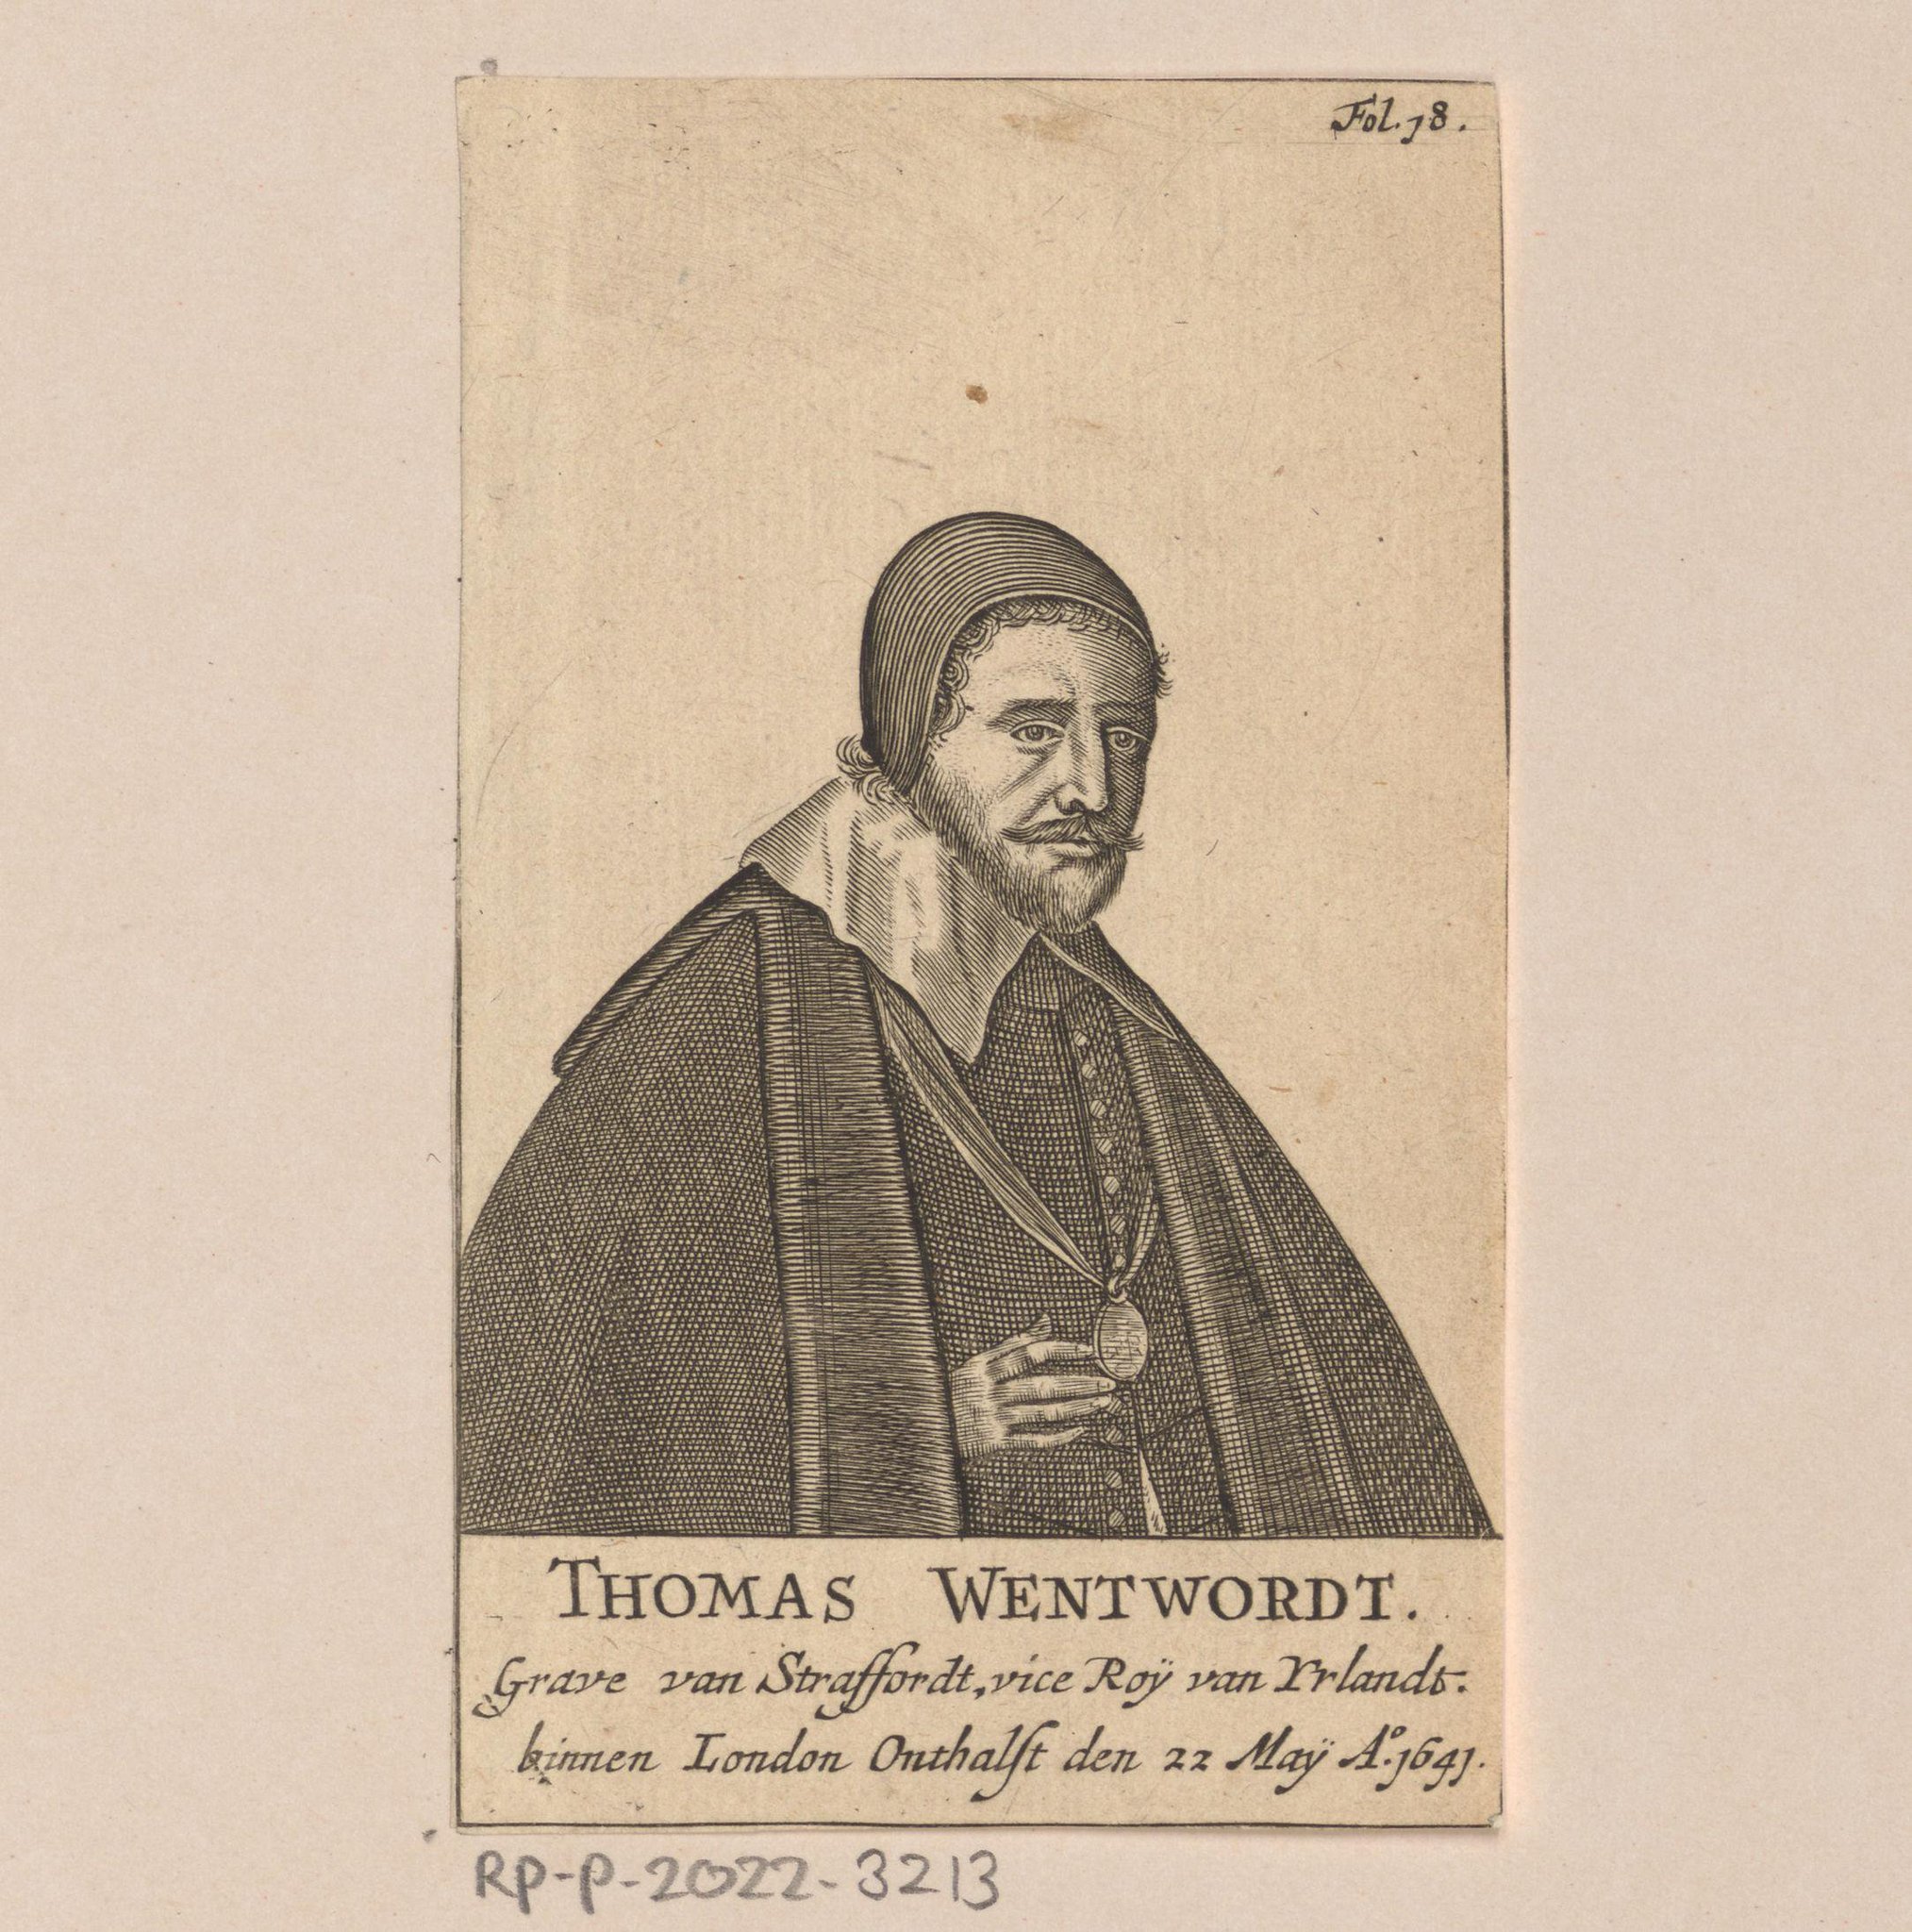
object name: print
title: Portret van Thomas Wentworth, eerste graaf van Strafford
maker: Anonymous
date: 1641-1699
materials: paper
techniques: engraving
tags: london, politician, historical persons, other sovereign (with title), politician, e.g. party leader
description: Met tweeregelig onderschrift in het Nederlands. Rechtsboven: Fol. 18.